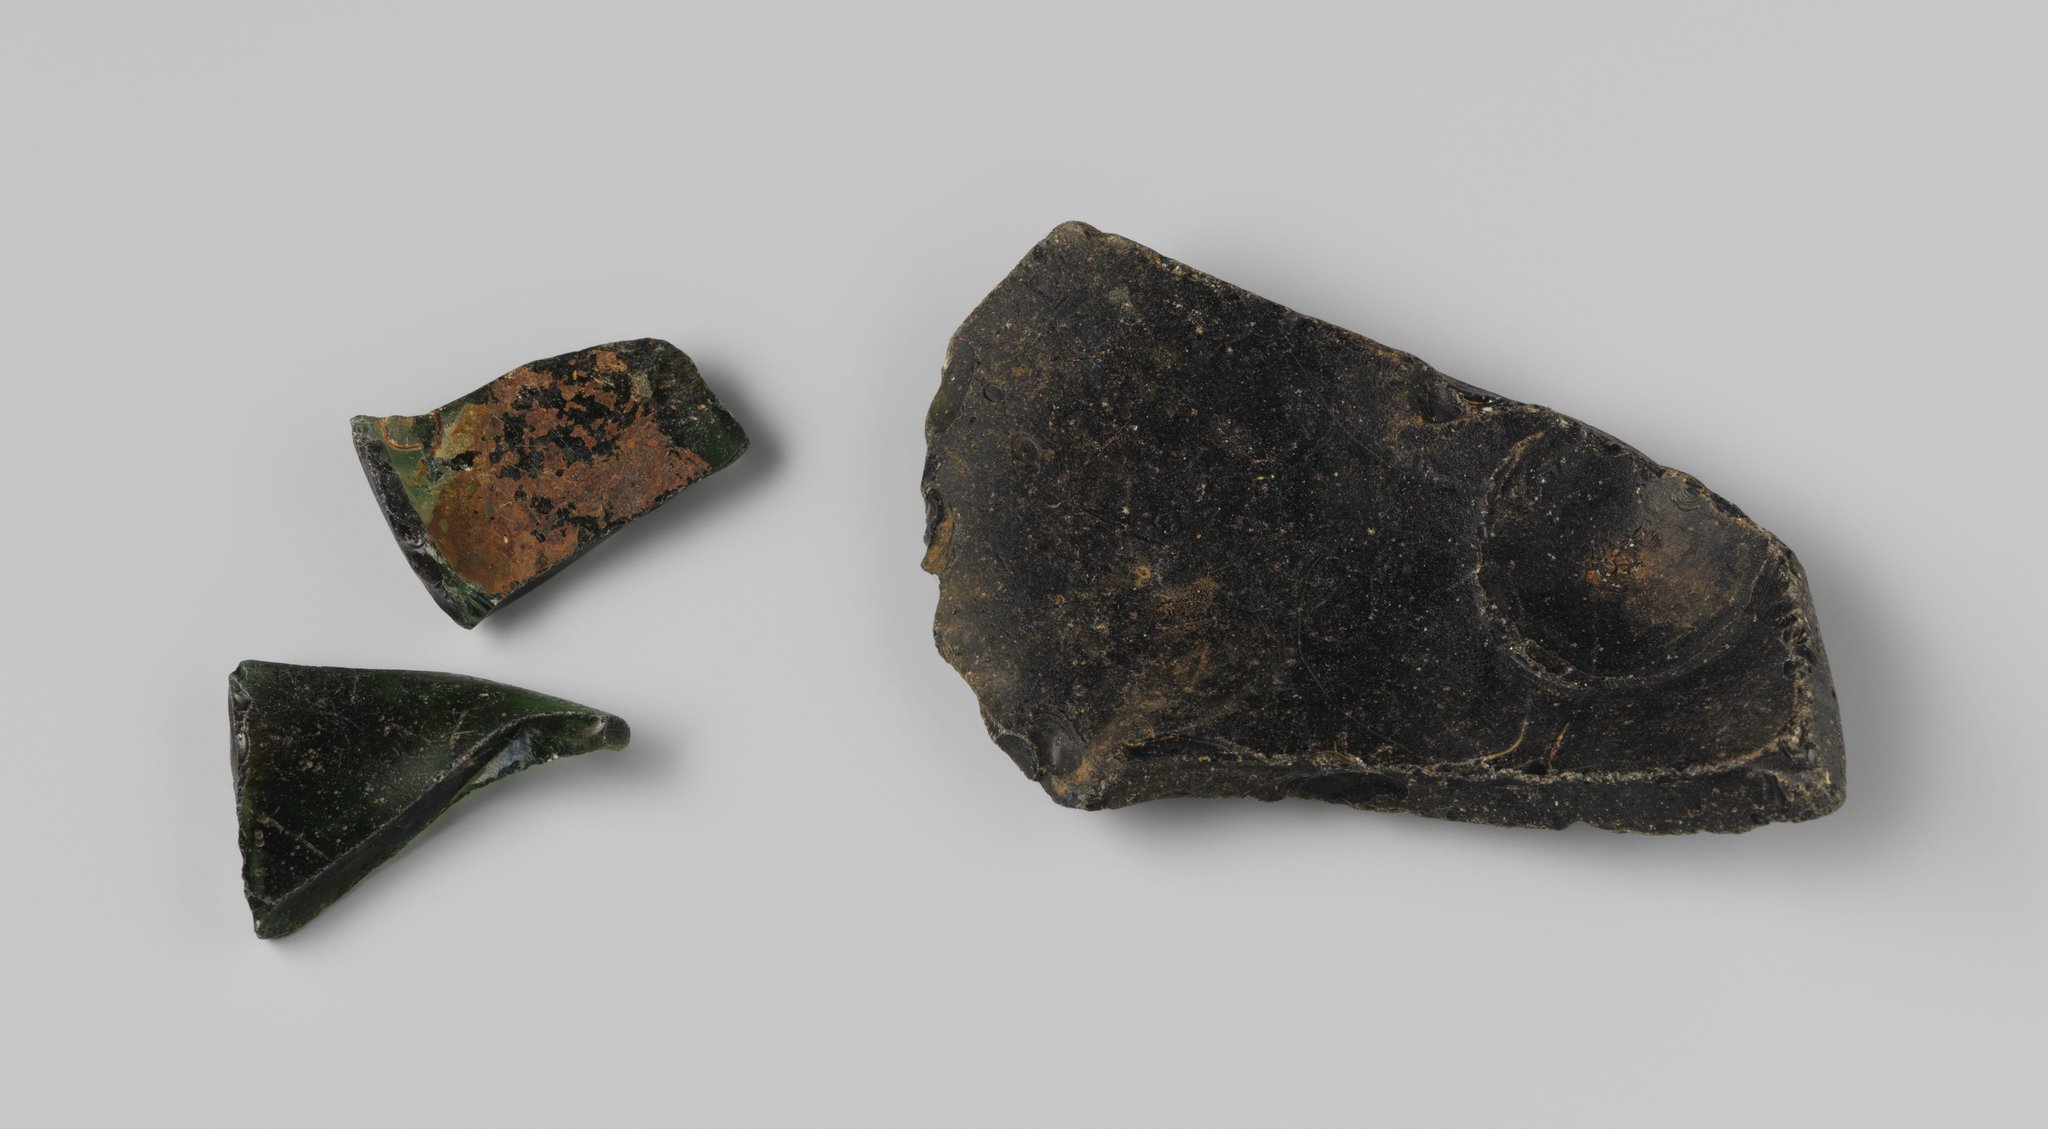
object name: bottle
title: Scherven van flessen uit het wrak van de Oostindiëvaarder Hollandia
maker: Anonymous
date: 1700-1743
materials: glass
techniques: green glass